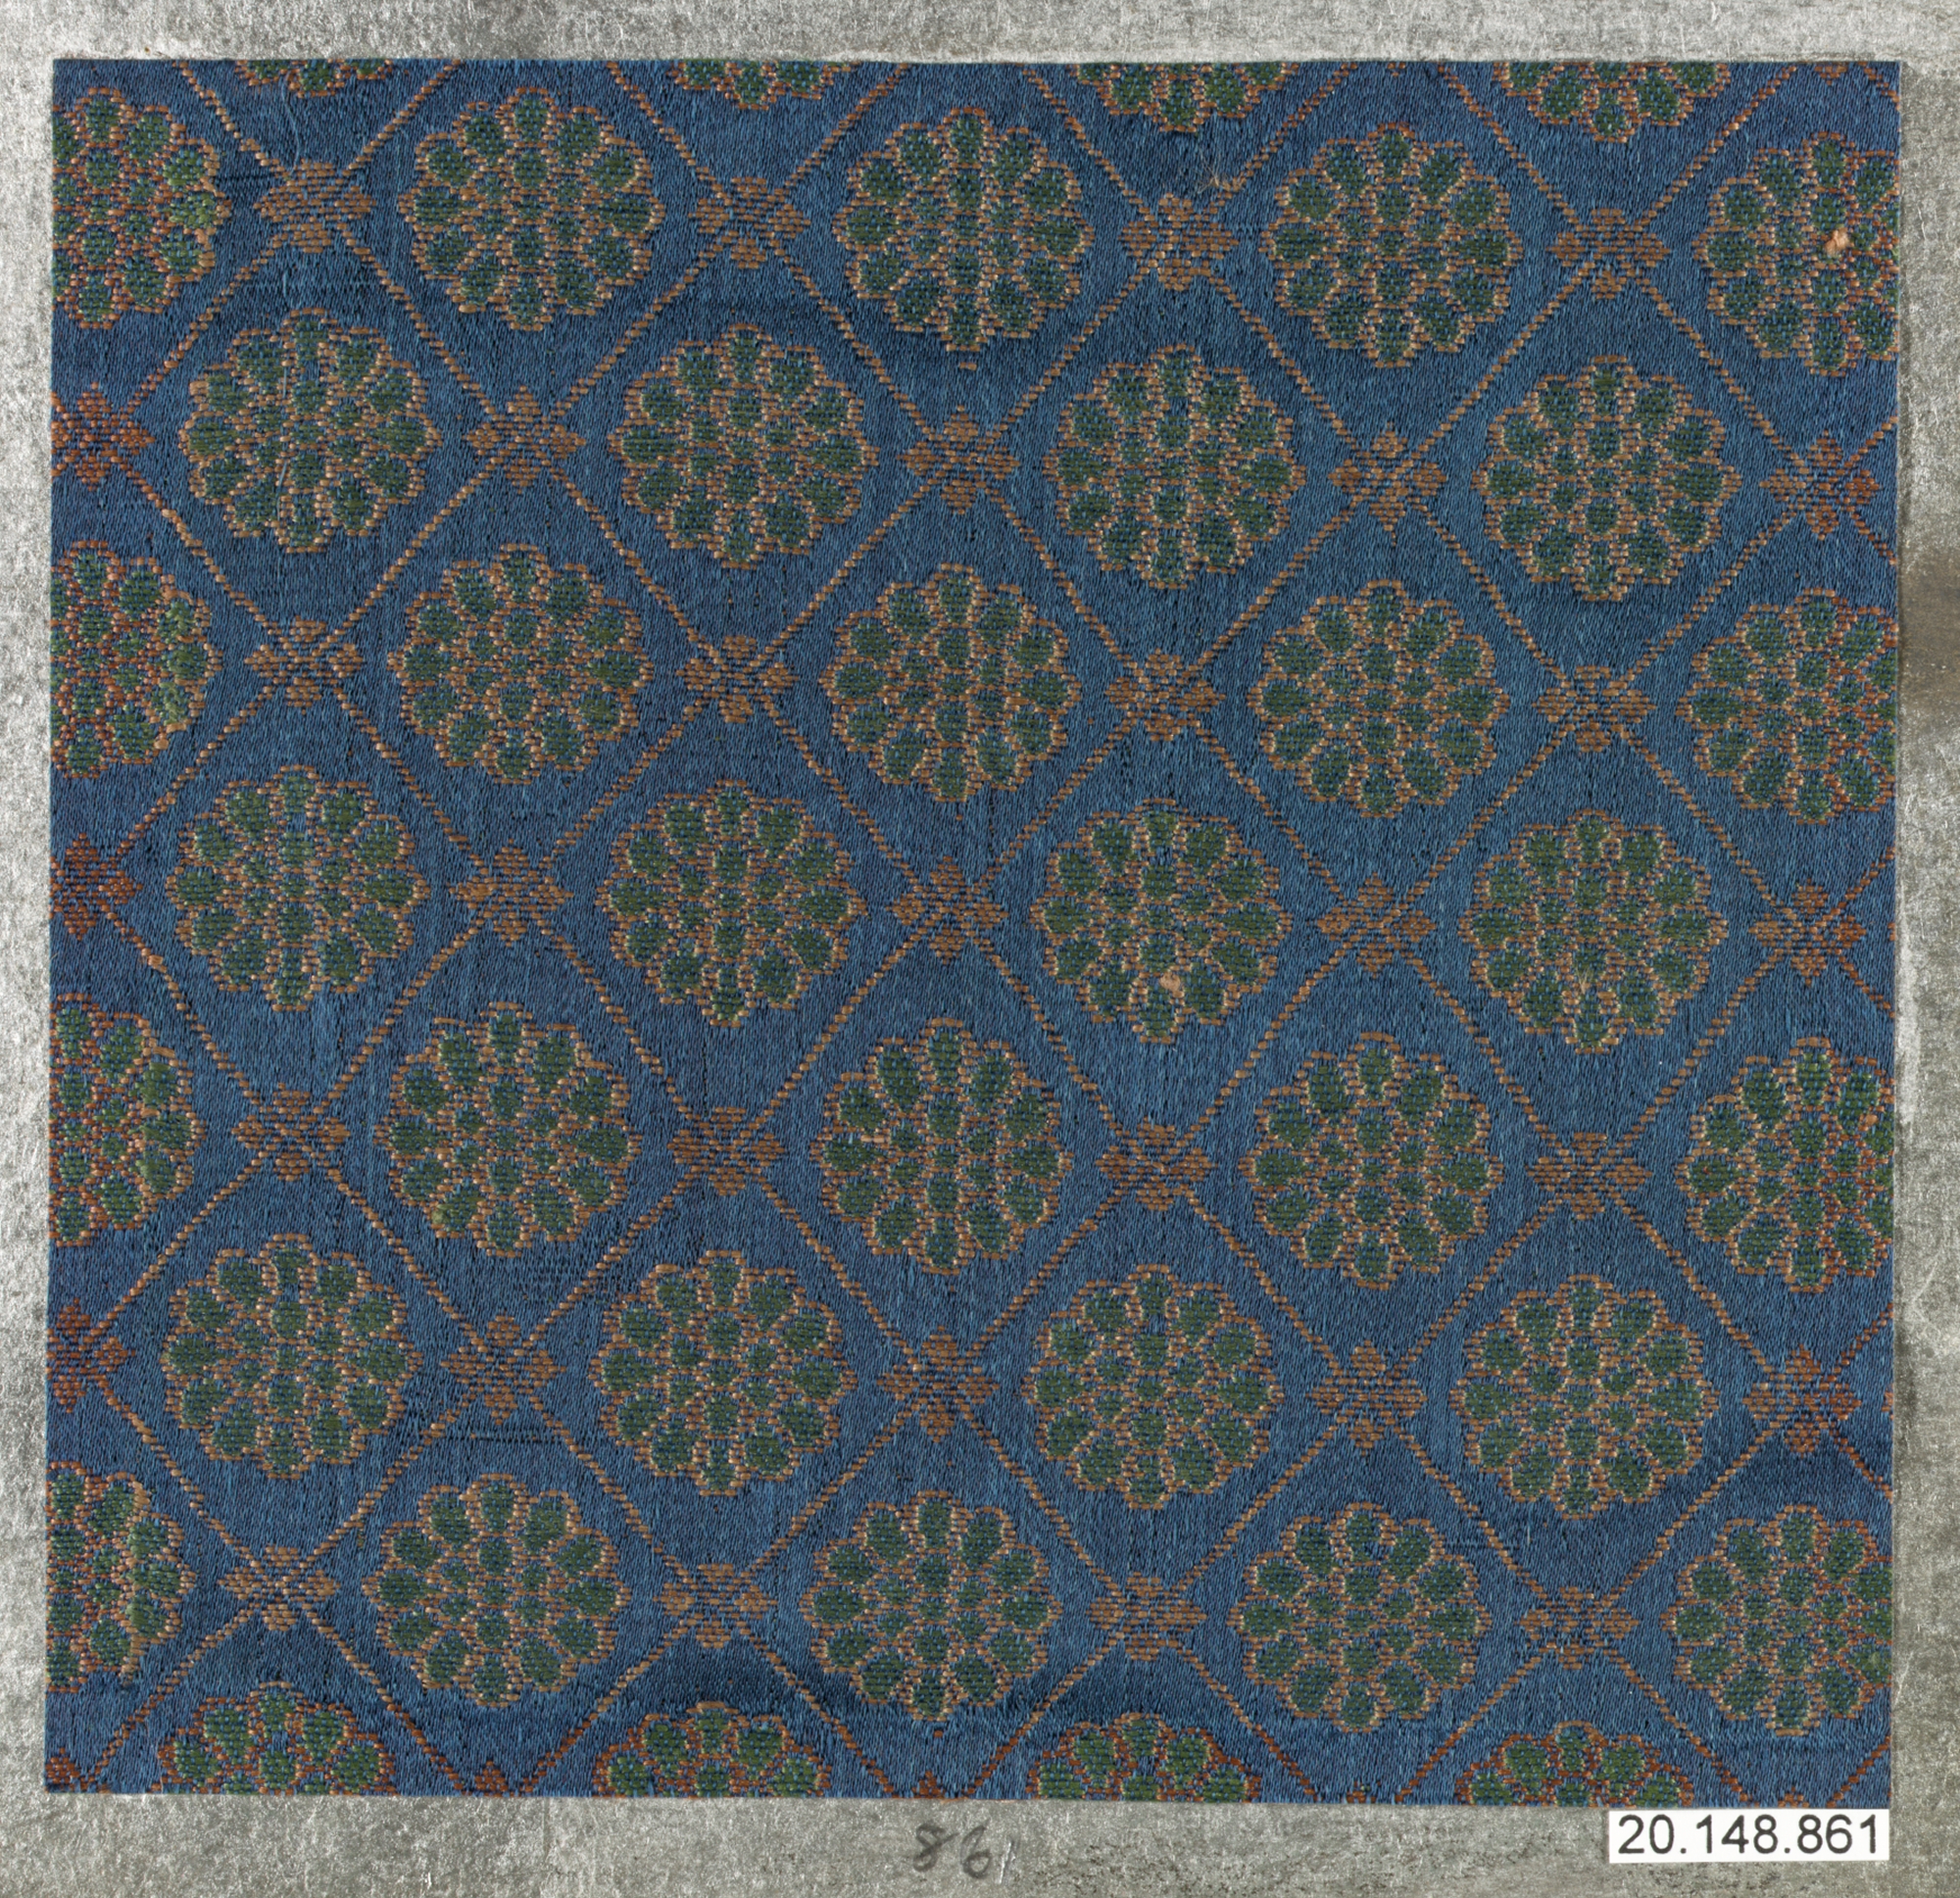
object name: piece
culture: japanese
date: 1701-1800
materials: silk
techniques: compound weave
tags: flowers